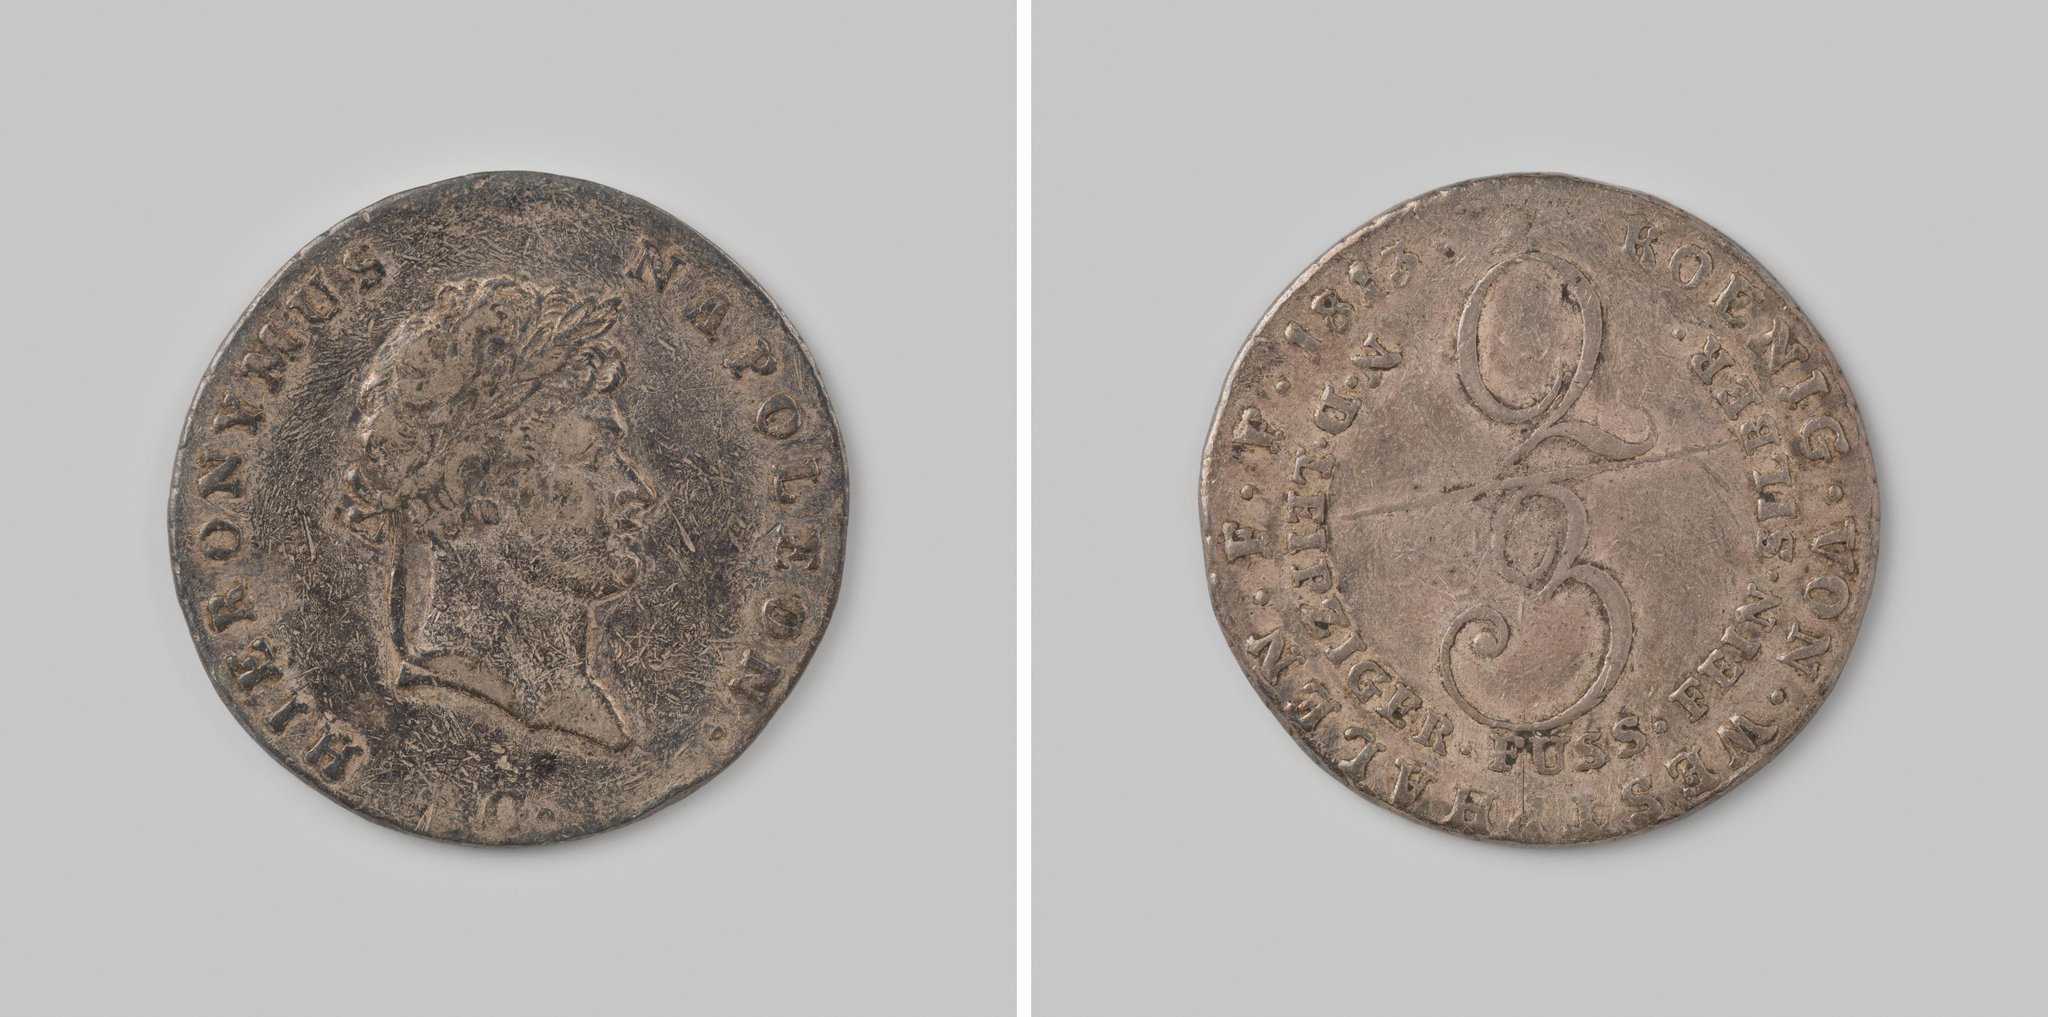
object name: coin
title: Tweederde taler uit het koninkrijk Westfalen van Jérome Napoléon, 1813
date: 1813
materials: silver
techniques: striking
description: Zilveren munt. Voorzijde: portret van de koning naar rechts. Daaronder letter C [=Kassel]. Keerzijde: waarde-aanduiding. Jaartal bovenaan in omschrift. Kartelrand.